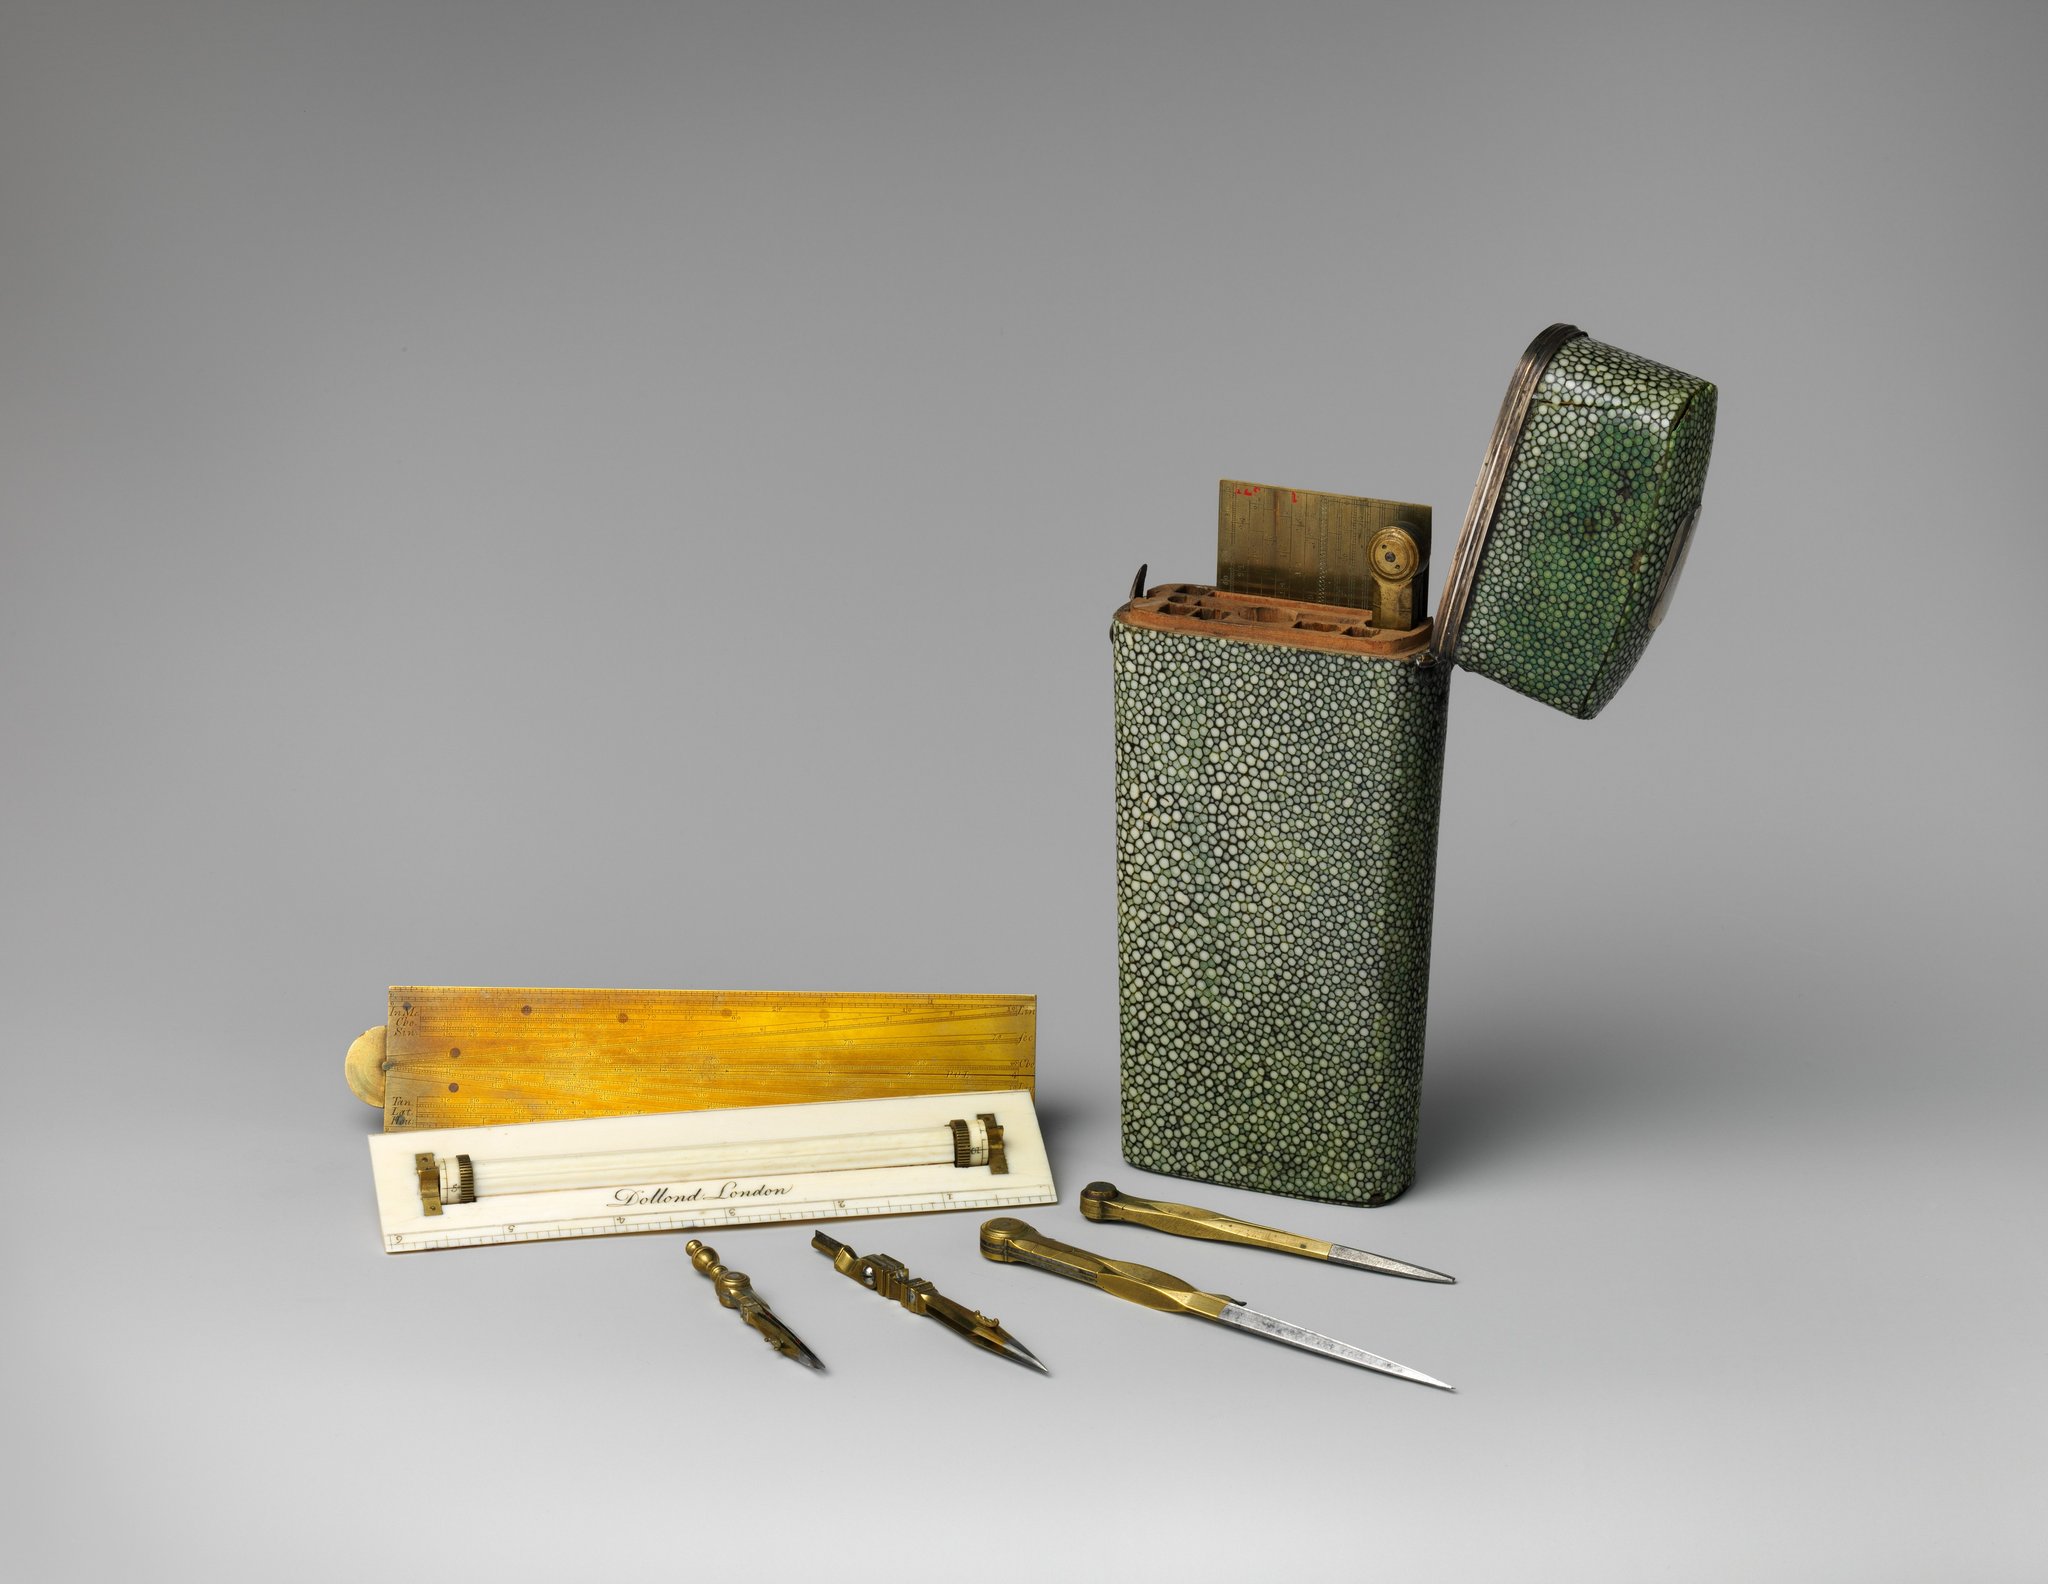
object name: pocket set of drawing instrument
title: Pocket set of drawing instruments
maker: peter dollond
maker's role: maker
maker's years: 1730-1820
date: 1755-1760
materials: brass, ivory, silver, steel